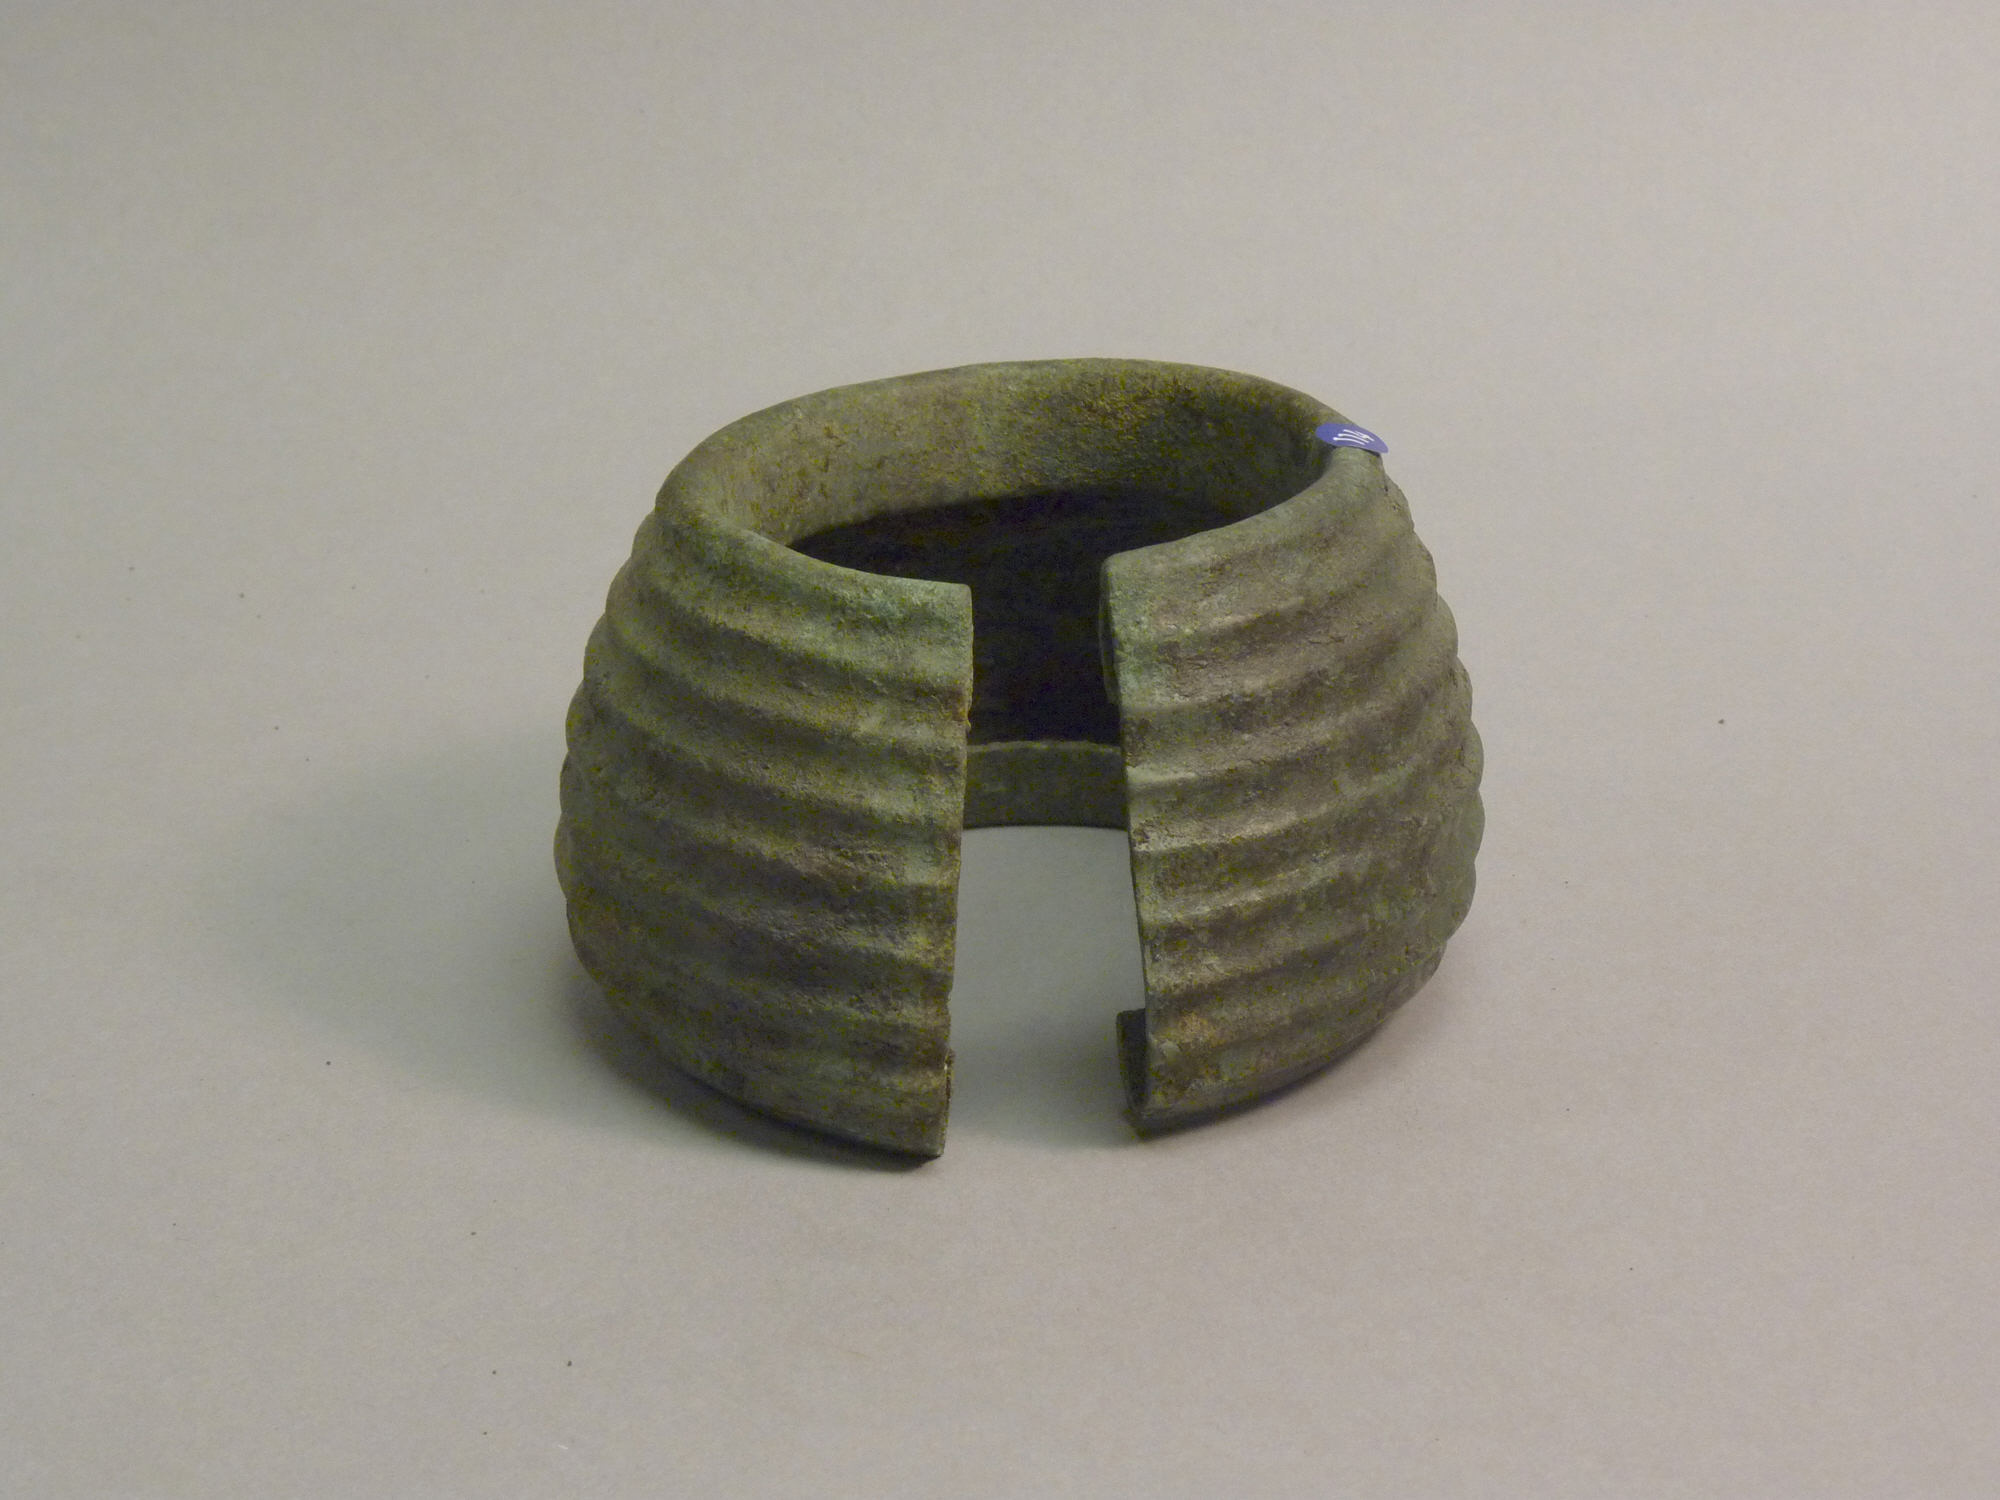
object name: bangle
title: Hollow Bangle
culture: thai or vietnamese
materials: bronze